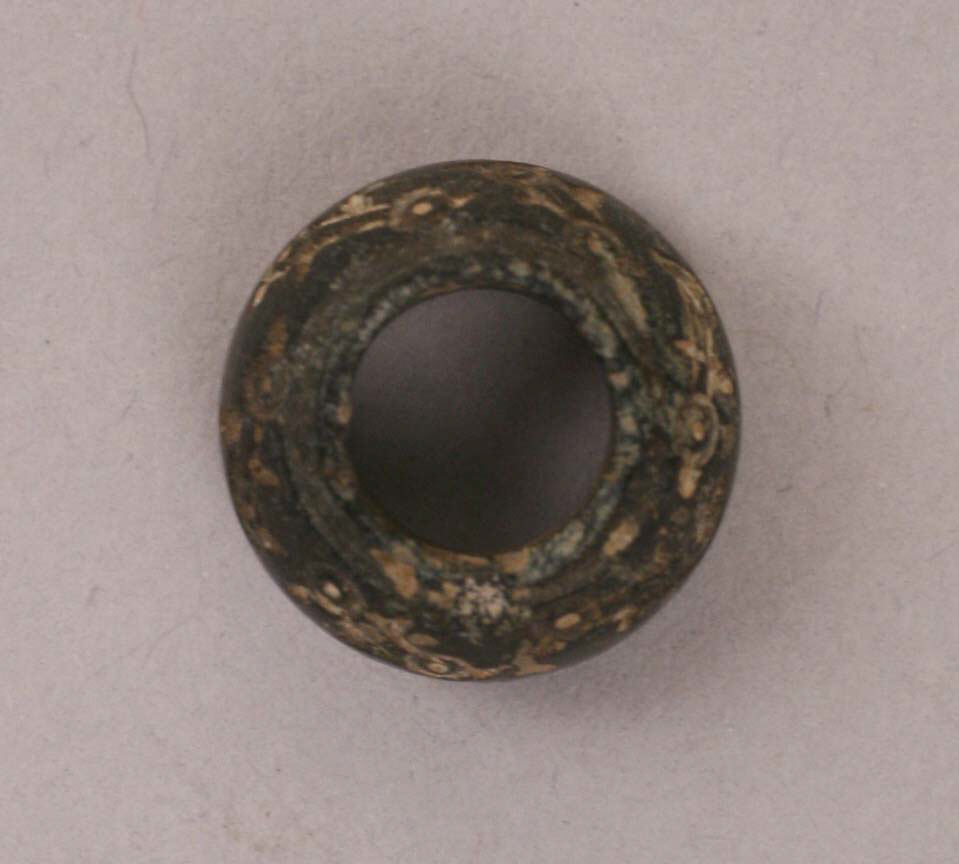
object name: button or bead or spindle whorl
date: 701-1000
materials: stone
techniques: incising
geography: iran